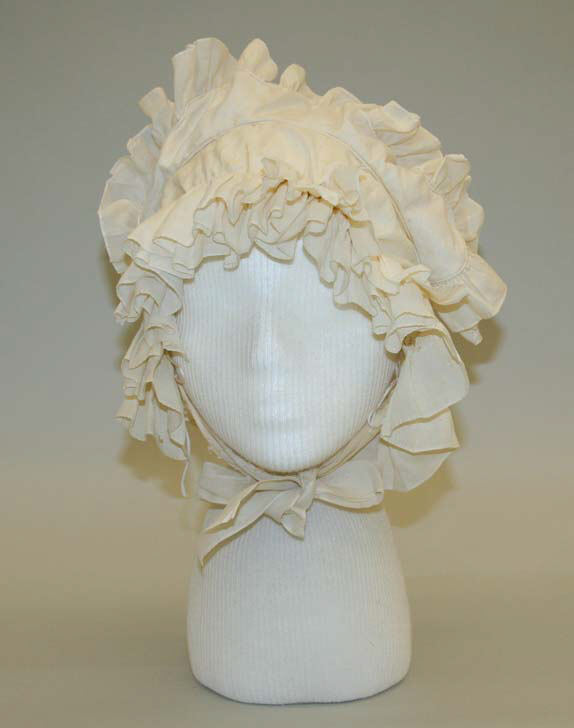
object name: cap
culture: american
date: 1830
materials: cotton